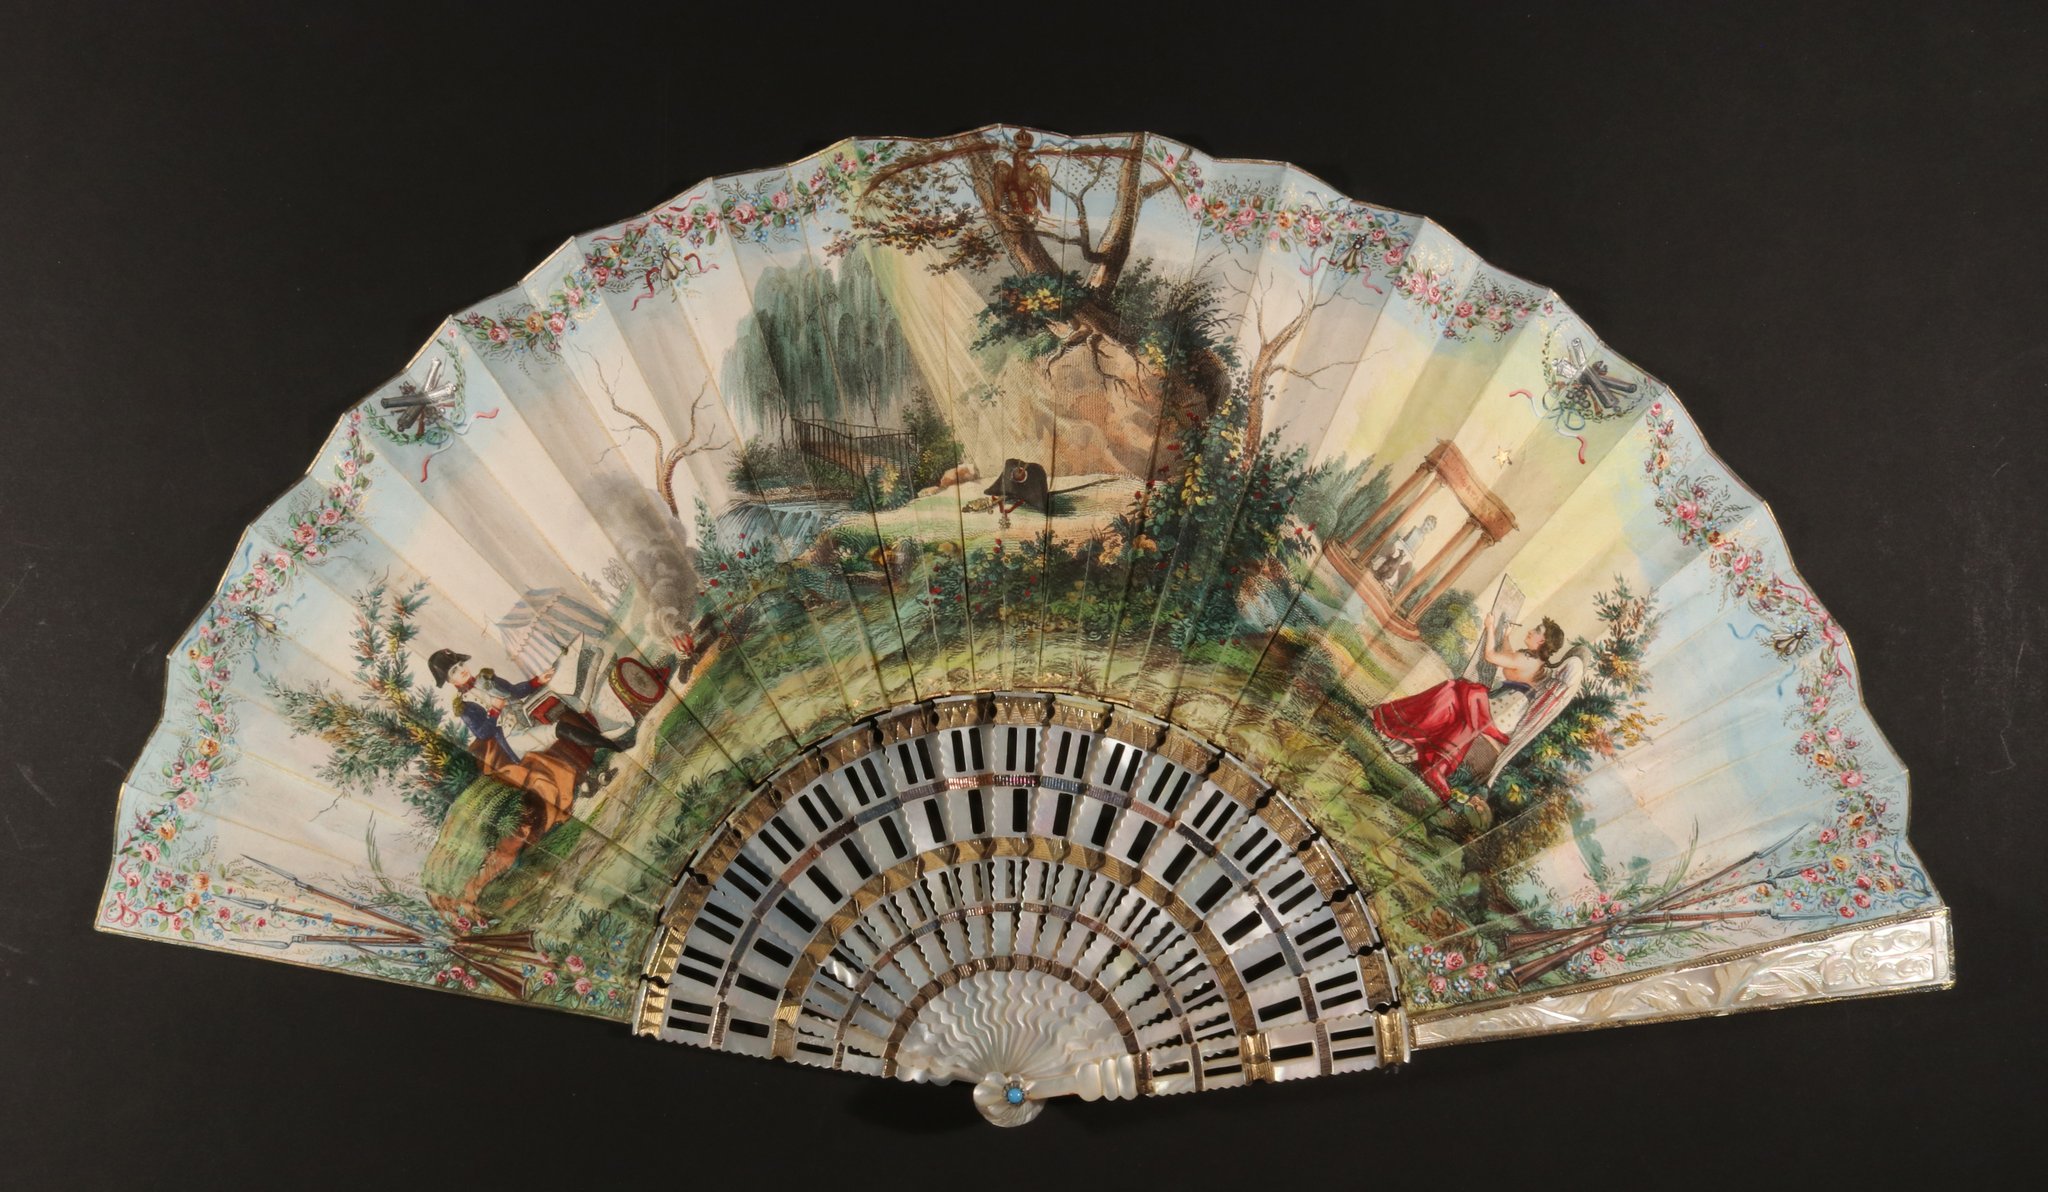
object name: fan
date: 1821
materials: mother of pearl, paper, parchment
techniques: gilding, hand coloring, etching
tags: napoleon i